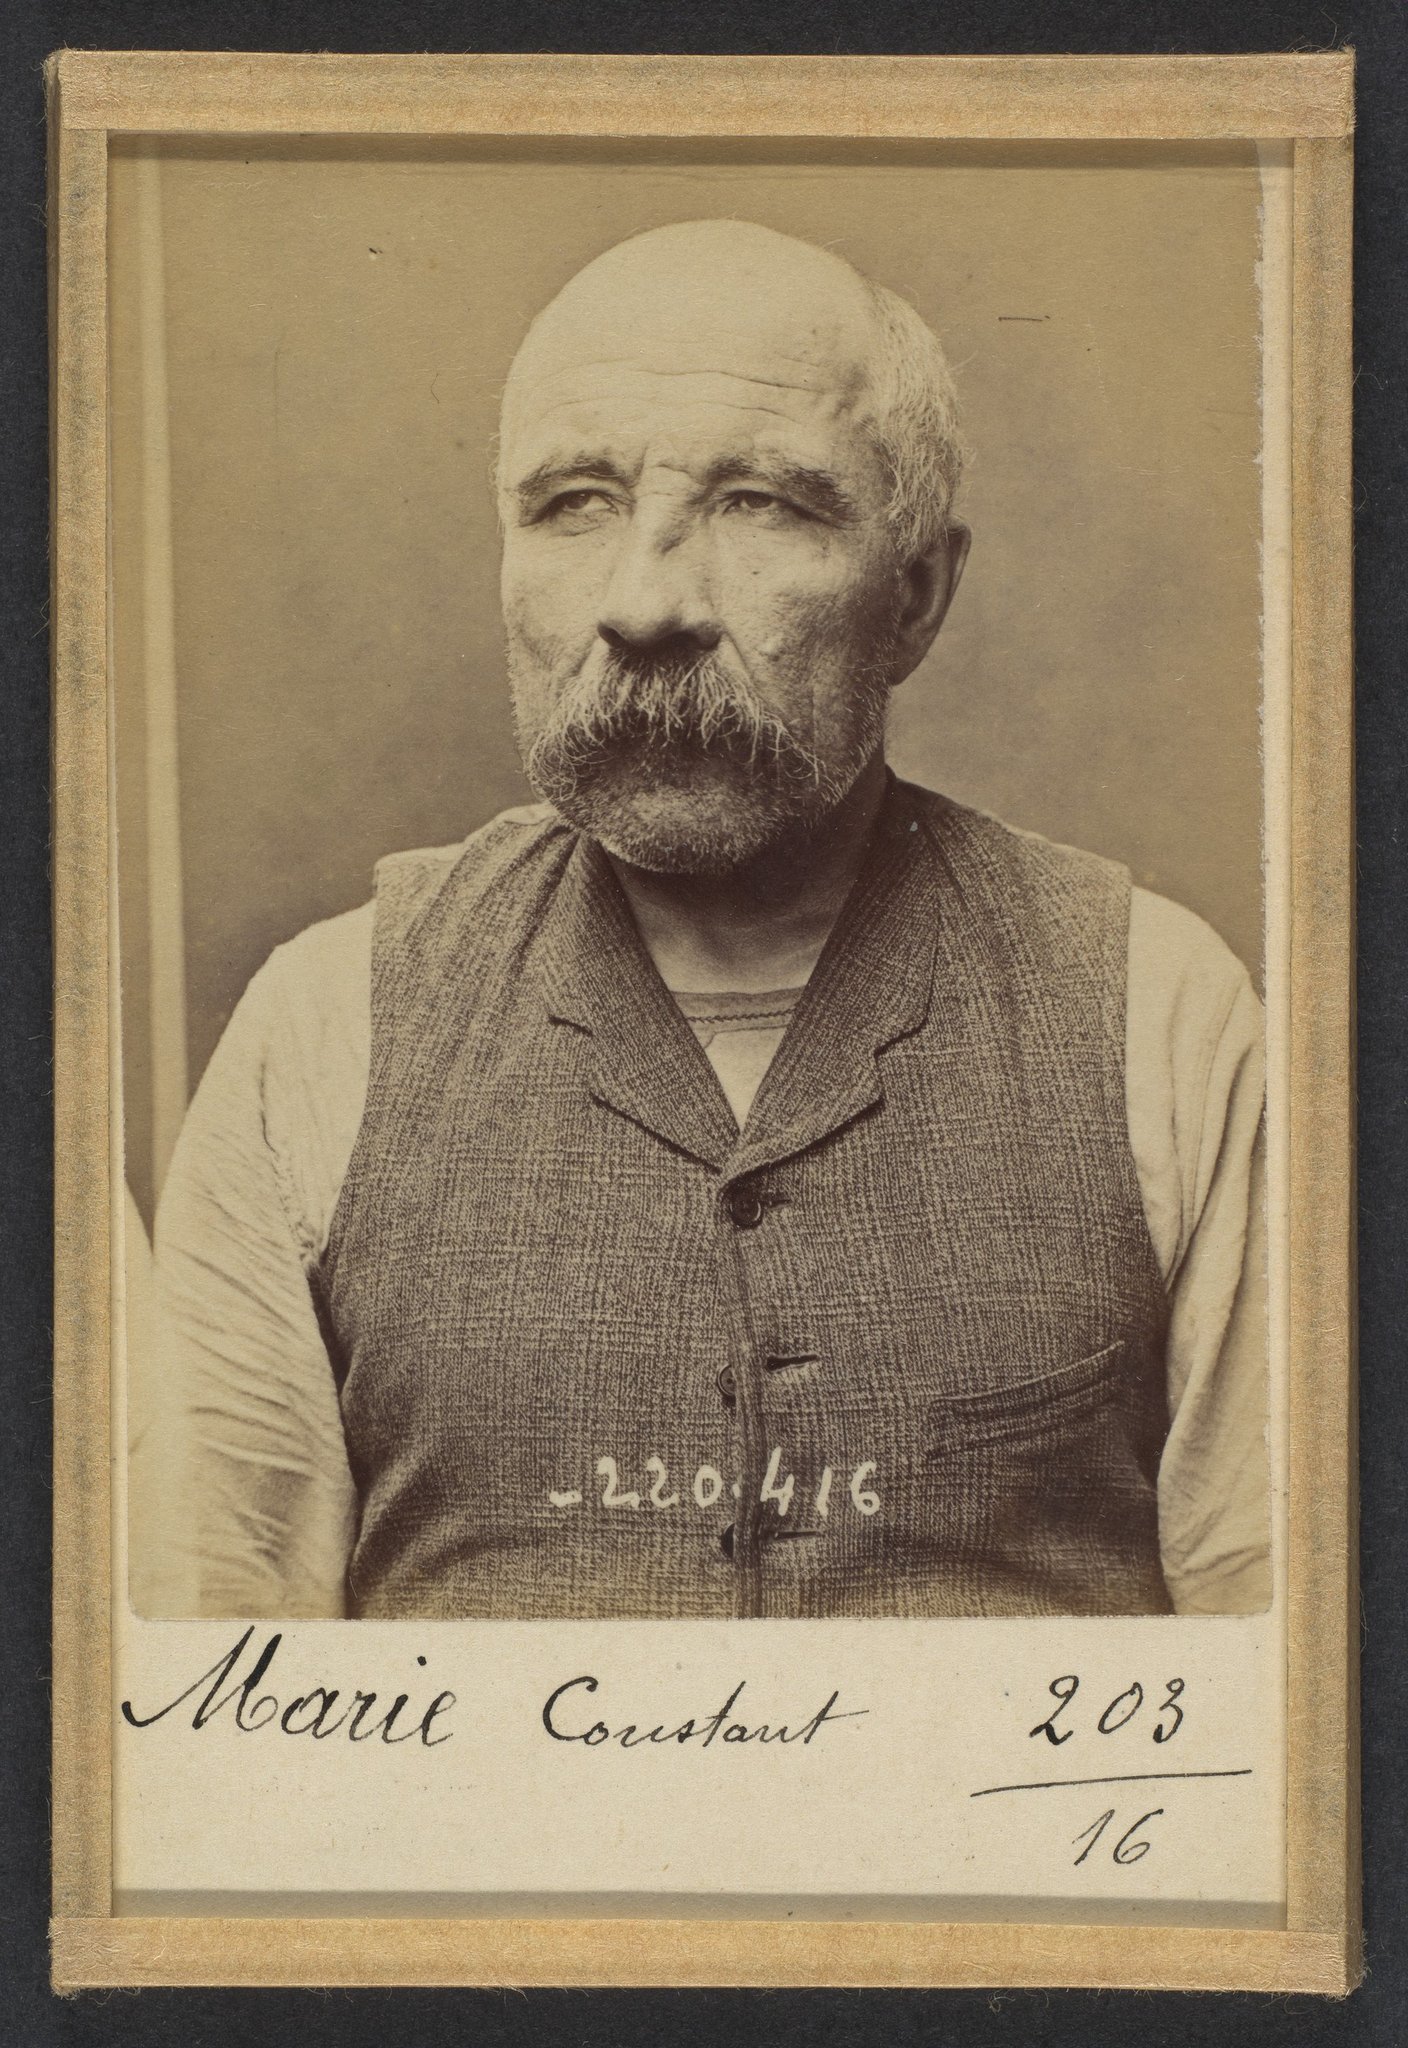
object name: mugshot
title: Marie. Constant. 53 ans, né le 27/8/38 à Ste-Houvrince (Calvados). Garçon rnarçon. Anarchiste. 2/7/94.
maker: alphonse bertillon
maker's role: artist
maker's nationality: french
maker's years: 1853-1914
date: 1894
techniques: albumen silver print, glass negative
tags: men,portraits